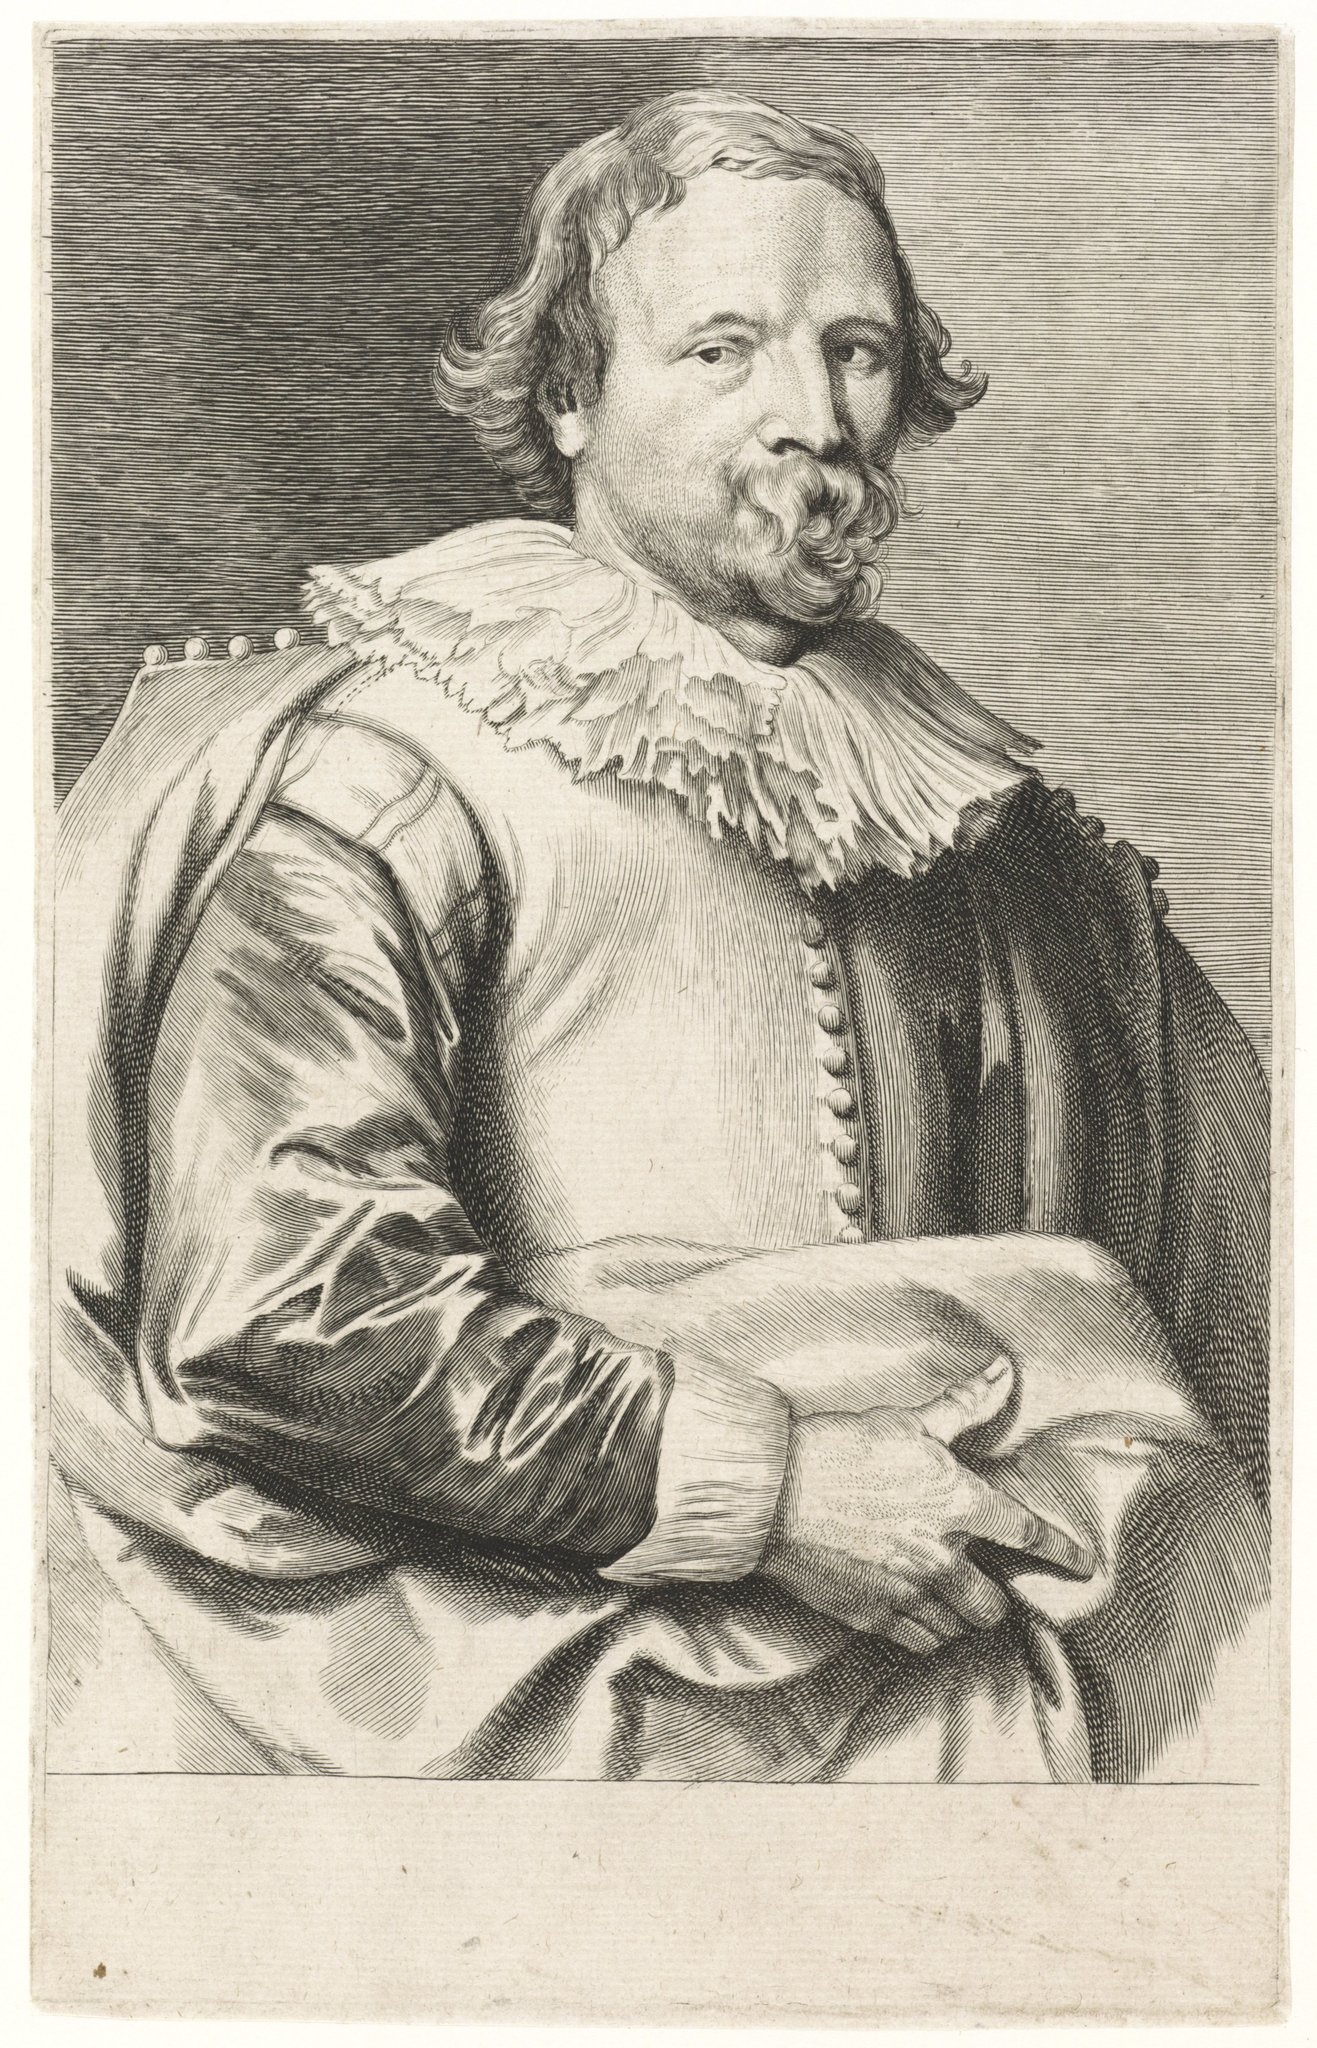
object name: print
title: Iconographie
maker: lucas vorsterman (i)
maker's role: print maker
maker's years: 1595-1675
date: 1630-1646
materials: paper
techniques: engraving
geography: antwerp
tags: antwerp, sculptor, johannes van mildert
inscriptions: collector's mark: Lugt 240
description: Prent gebruikt voor: Icones principum, virorum doctorum, pictorum, chalcographorum, statuariorum nec non amatorum pictoriae artis numero centum ab Ant. van Dyck ad vivum expressae ejusque sumptibus aeri incisae. Antwerpen: Gillis Hendricx, [1645-1646].